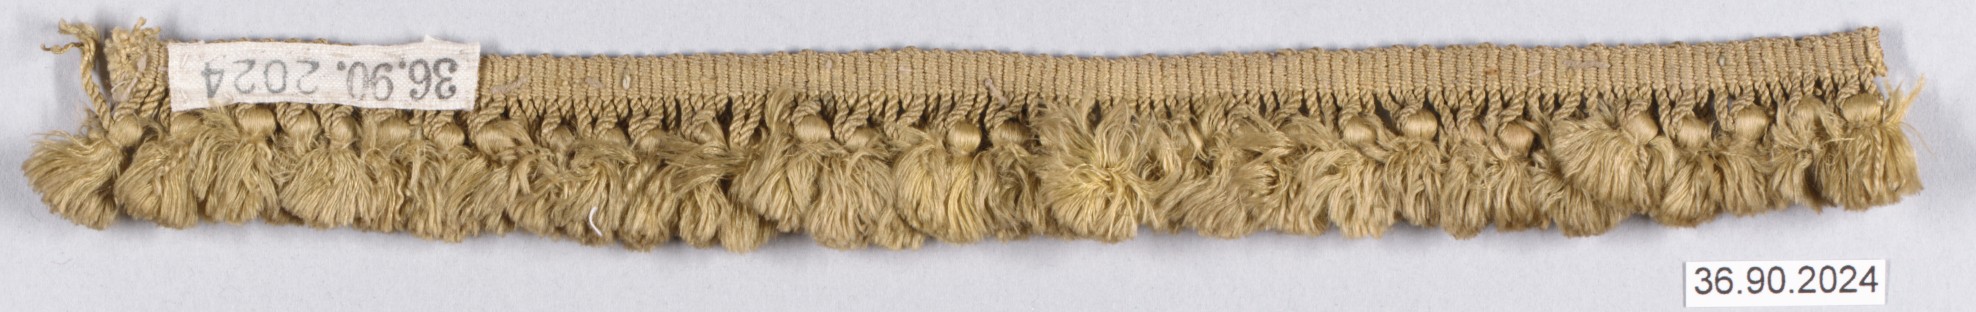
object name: fringe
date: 1750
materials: silk